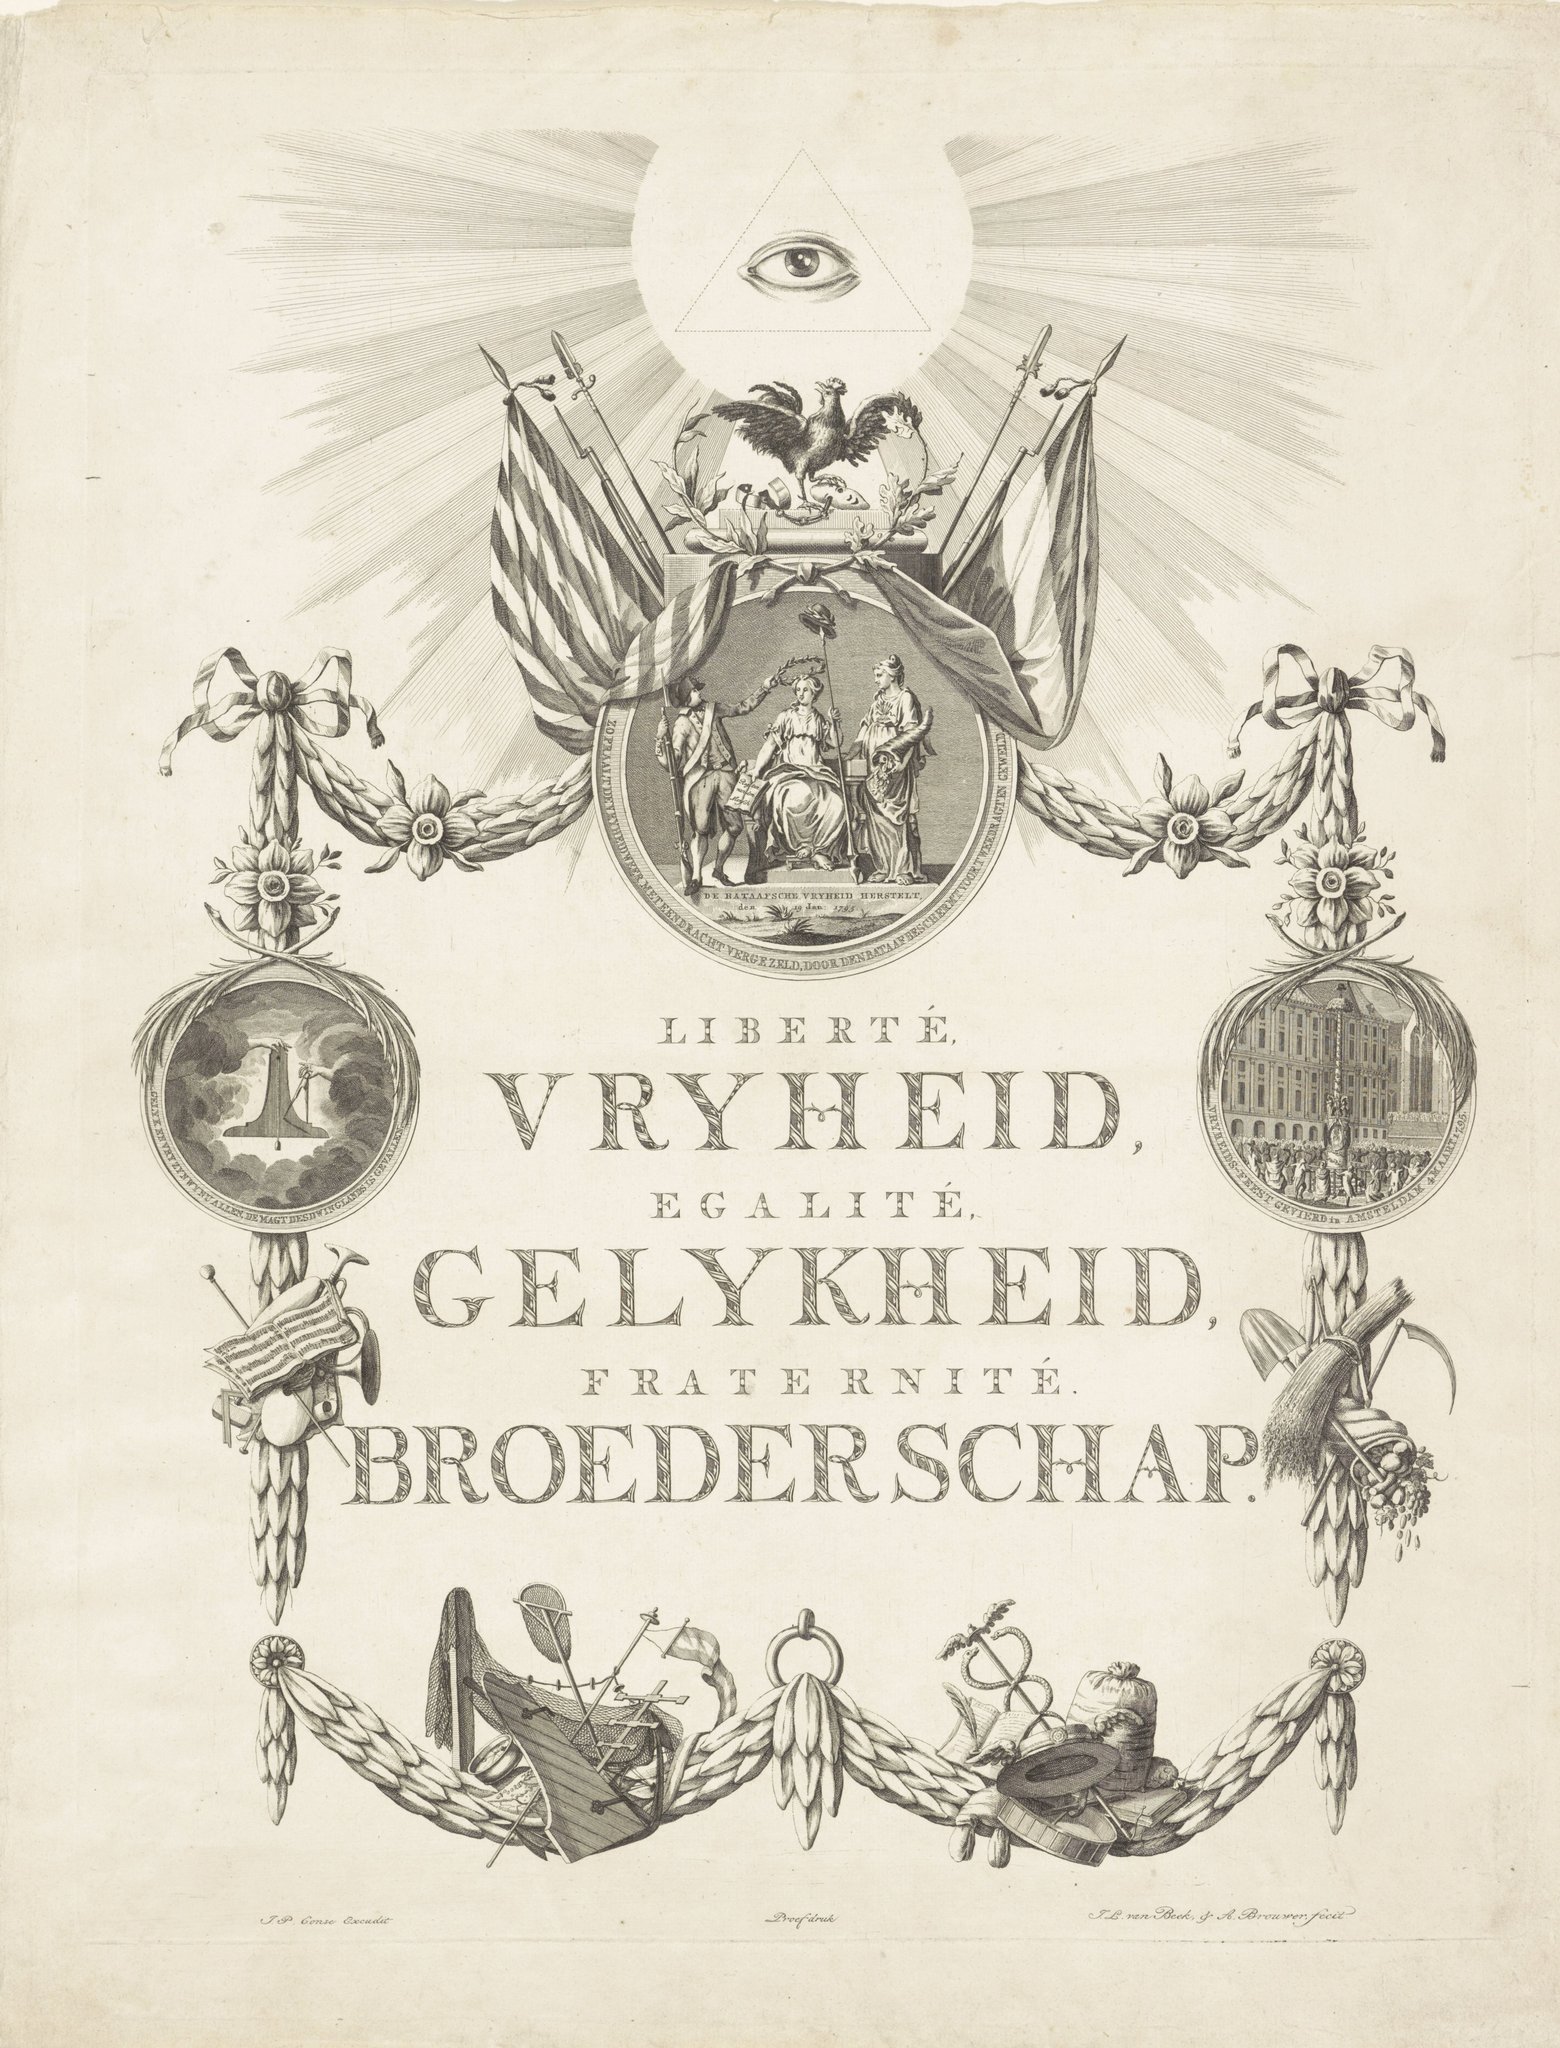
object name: print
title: Allegorie op de Vrijheid, Gelijkheid en Broederschap, 1795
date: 1795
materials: paper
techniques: engraving, etching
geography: netherlands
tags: the all-seeing eye, triangle with eye ~ symbol of god the father, freedom, liberty; 'libertà' (ripa) (+ abstract concept represented by female figure), equality, equity, fairness, righteousness; 'equalità', 'equità', 'giuditio giusto', 'ordine dritto e giusto', 'ugualità' (ripa) (+ symbolical representation of concept), dancing around the tree of liberty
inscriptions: collector's mark: Lugt 2228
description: Allegorie op de Vrijheid, Gelijkheid en Broederschap, 1795. Medaillons verbonden door festoenen. Centraal boven de Bataafse vrijheid hersteld in 1795, bekroond door de Franse haan en het Alziende Oog, Rechts het Vrijheidsfeest op de Dam te Amsterdam, links schietlood en passer van de Gelijkheid. Bij de prent behoort een gedrukte verklaring.